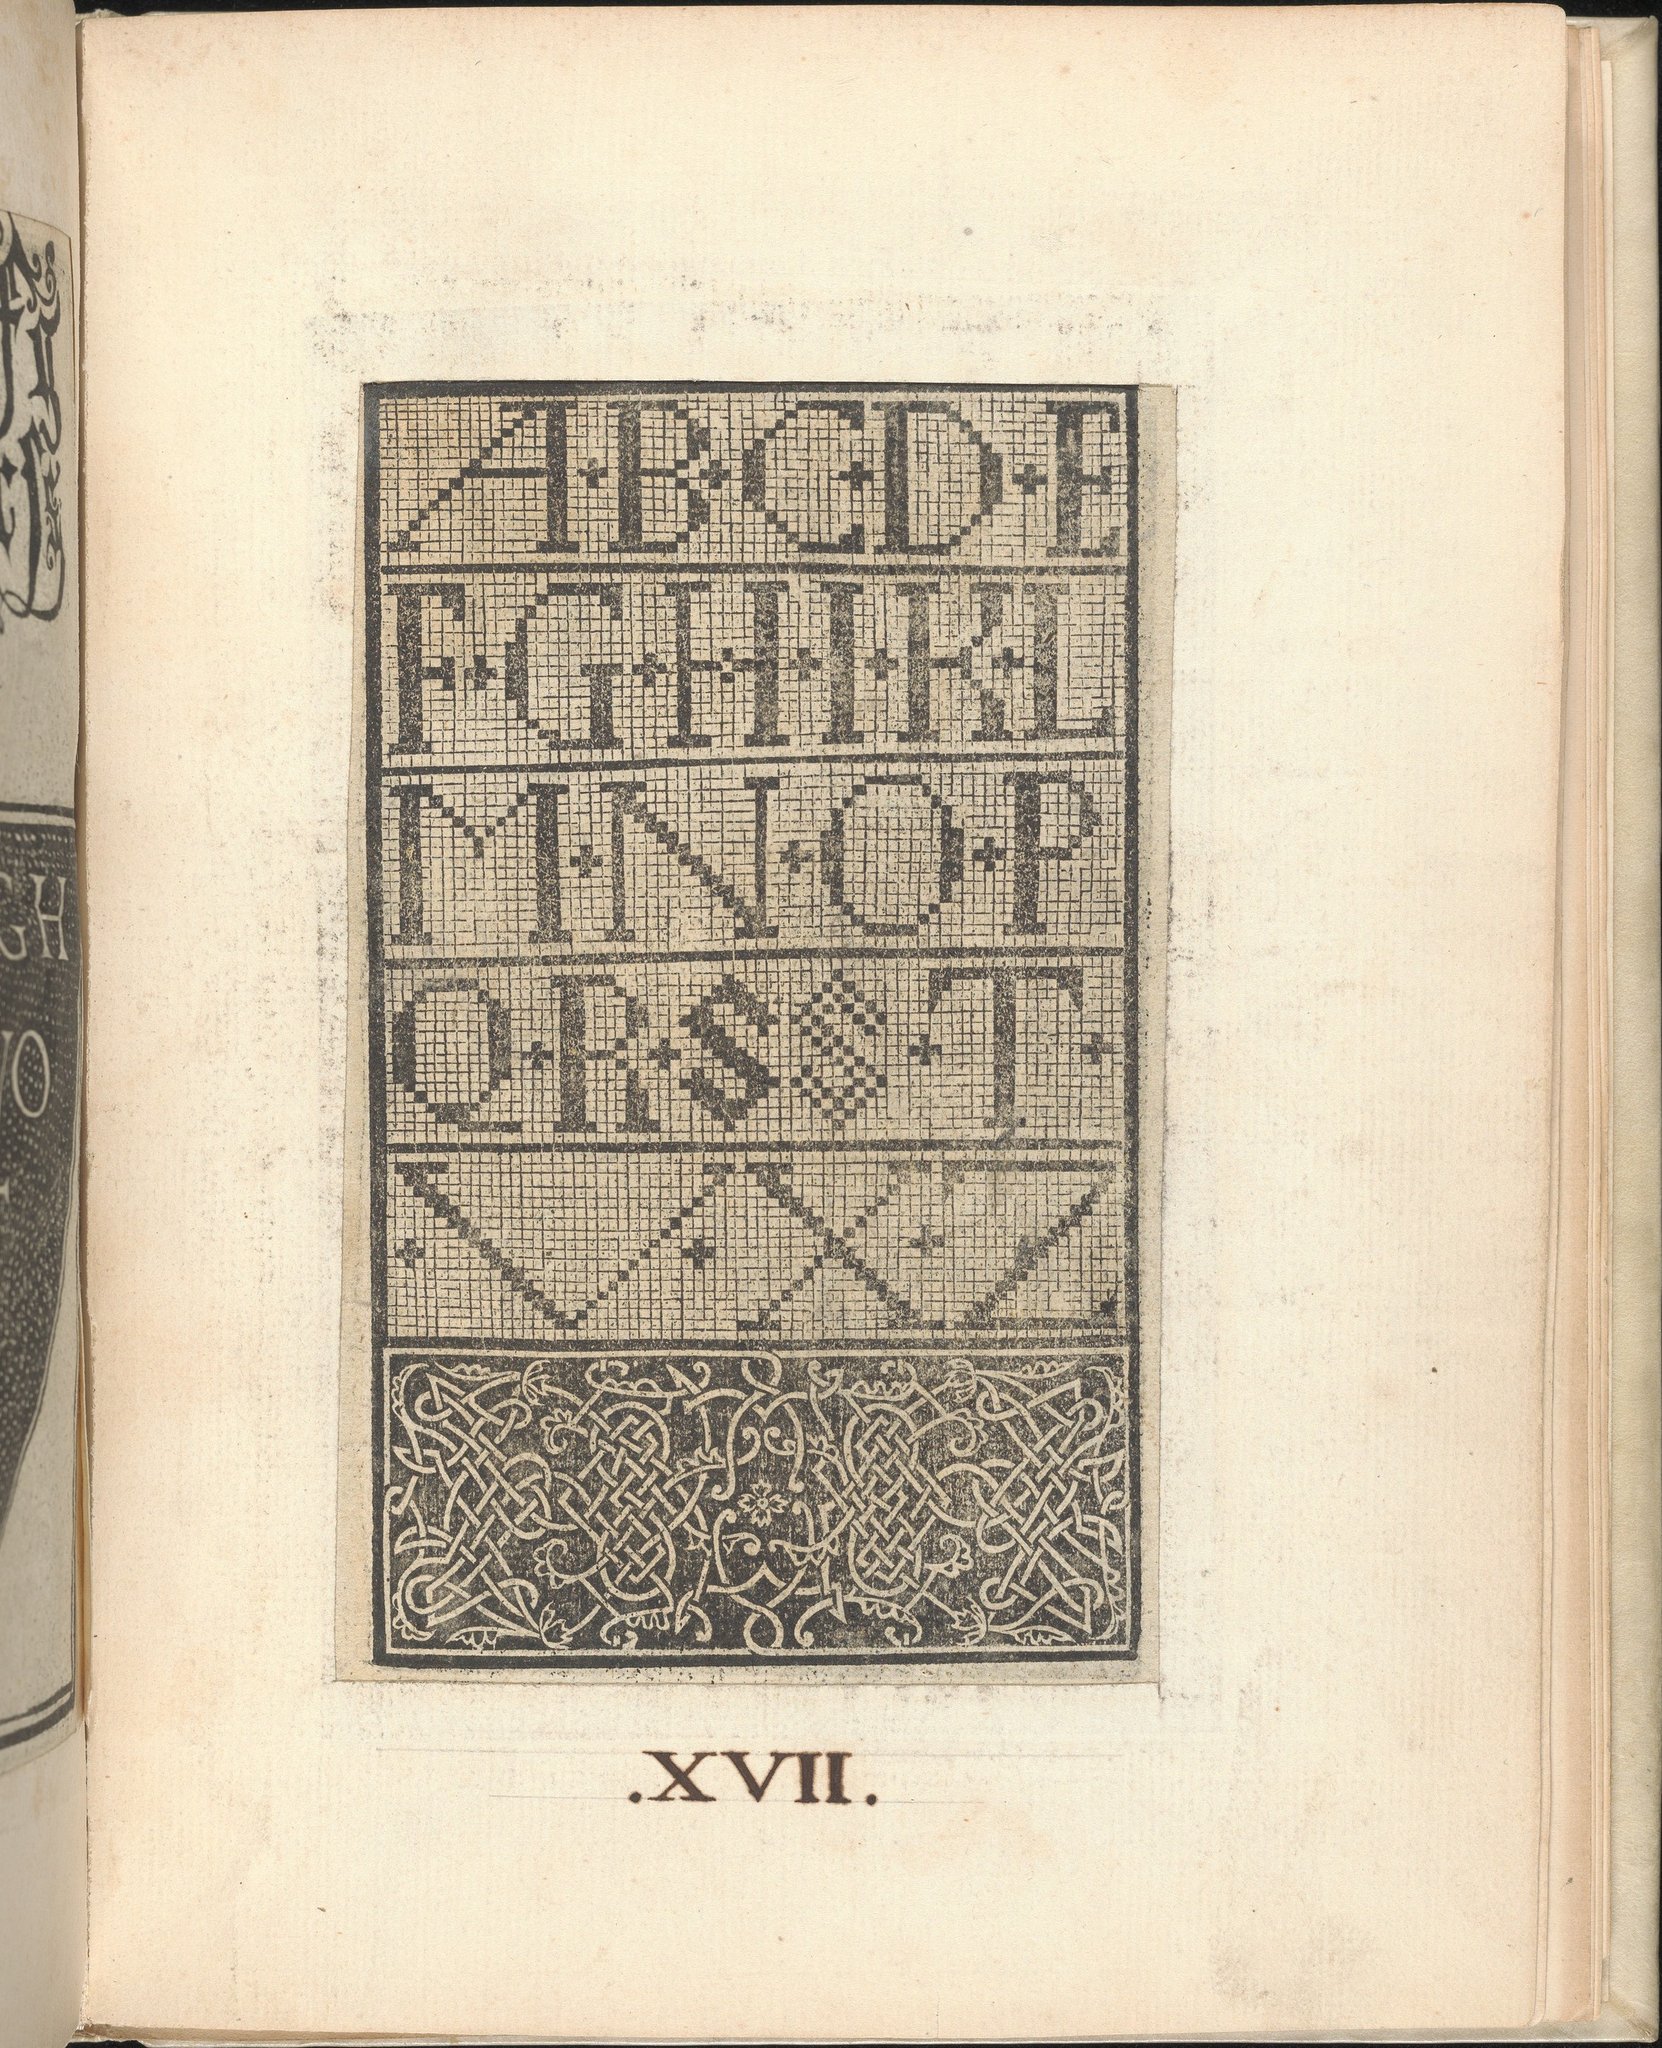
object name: book print ornament architecture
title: Esemplario di lavori, page 16 (verso)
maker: nicolò zoppino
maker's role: publisher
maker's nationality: italian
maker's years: 1478-1544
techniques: bookbinding, inlay, woodcut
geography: italy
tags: ornament